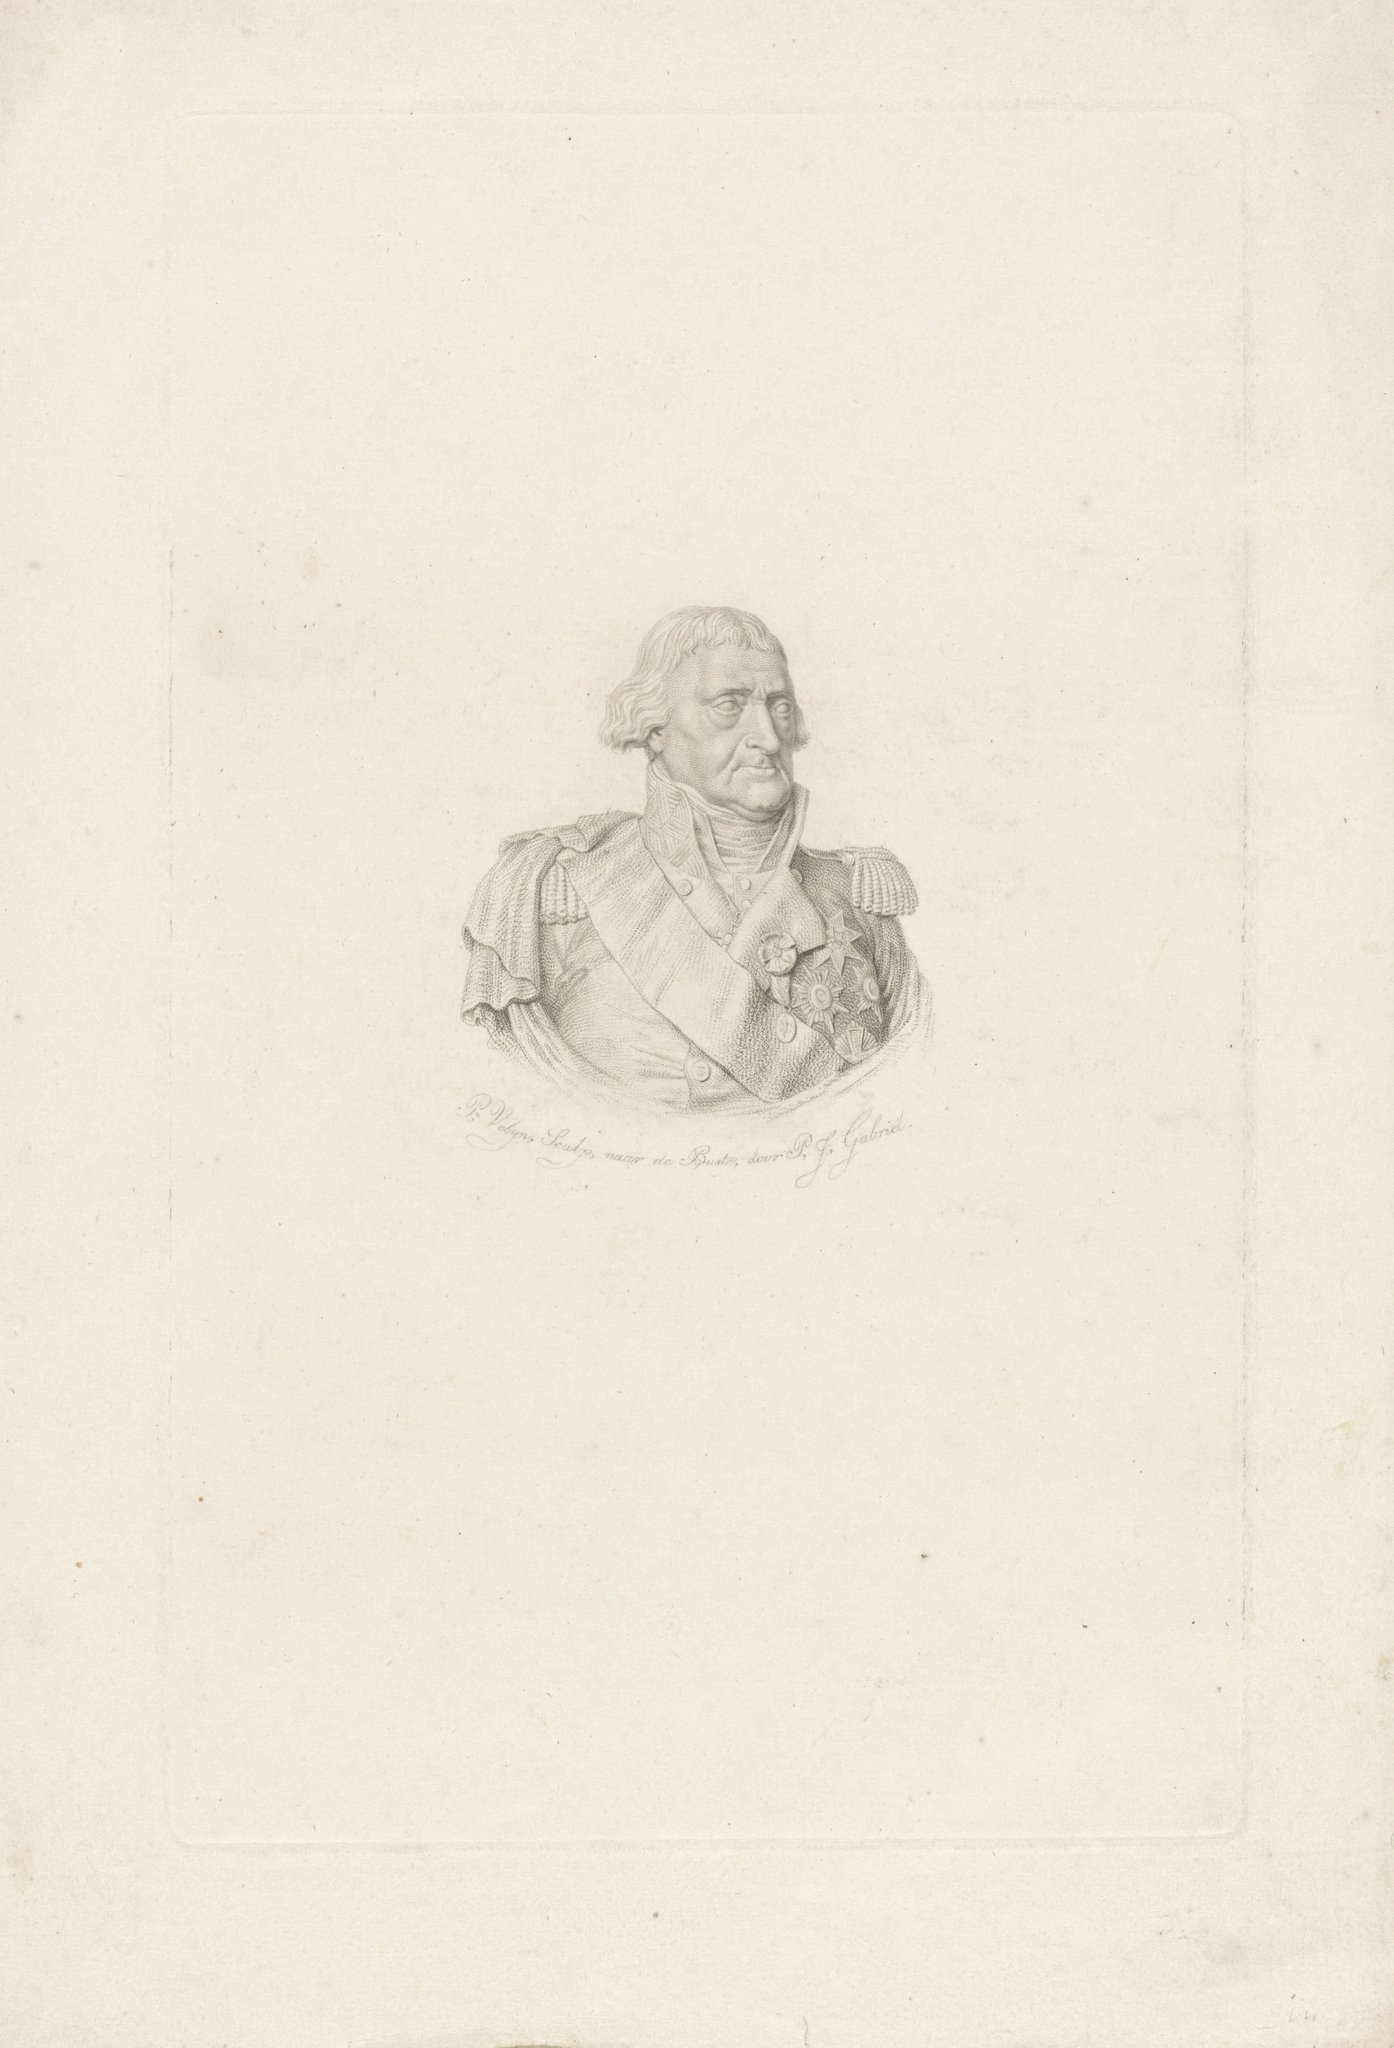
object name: print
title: Portret van jhr. Johan Hendrik van Kinsbergen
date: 1797-1836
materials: paper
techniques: stippled etching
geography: netherlands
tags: jonkheer jan hendrik van kinsbergen, piece of sculpture, reproduction of a piece of sculpture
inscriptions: collector's mark: Lugt 2228, collector's mark: Lugt 2760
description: Portret van luitenant-admiraal Johan Hendrik van Kinsbergen, afbeelding van een gebeeldhouwde portretbuste.